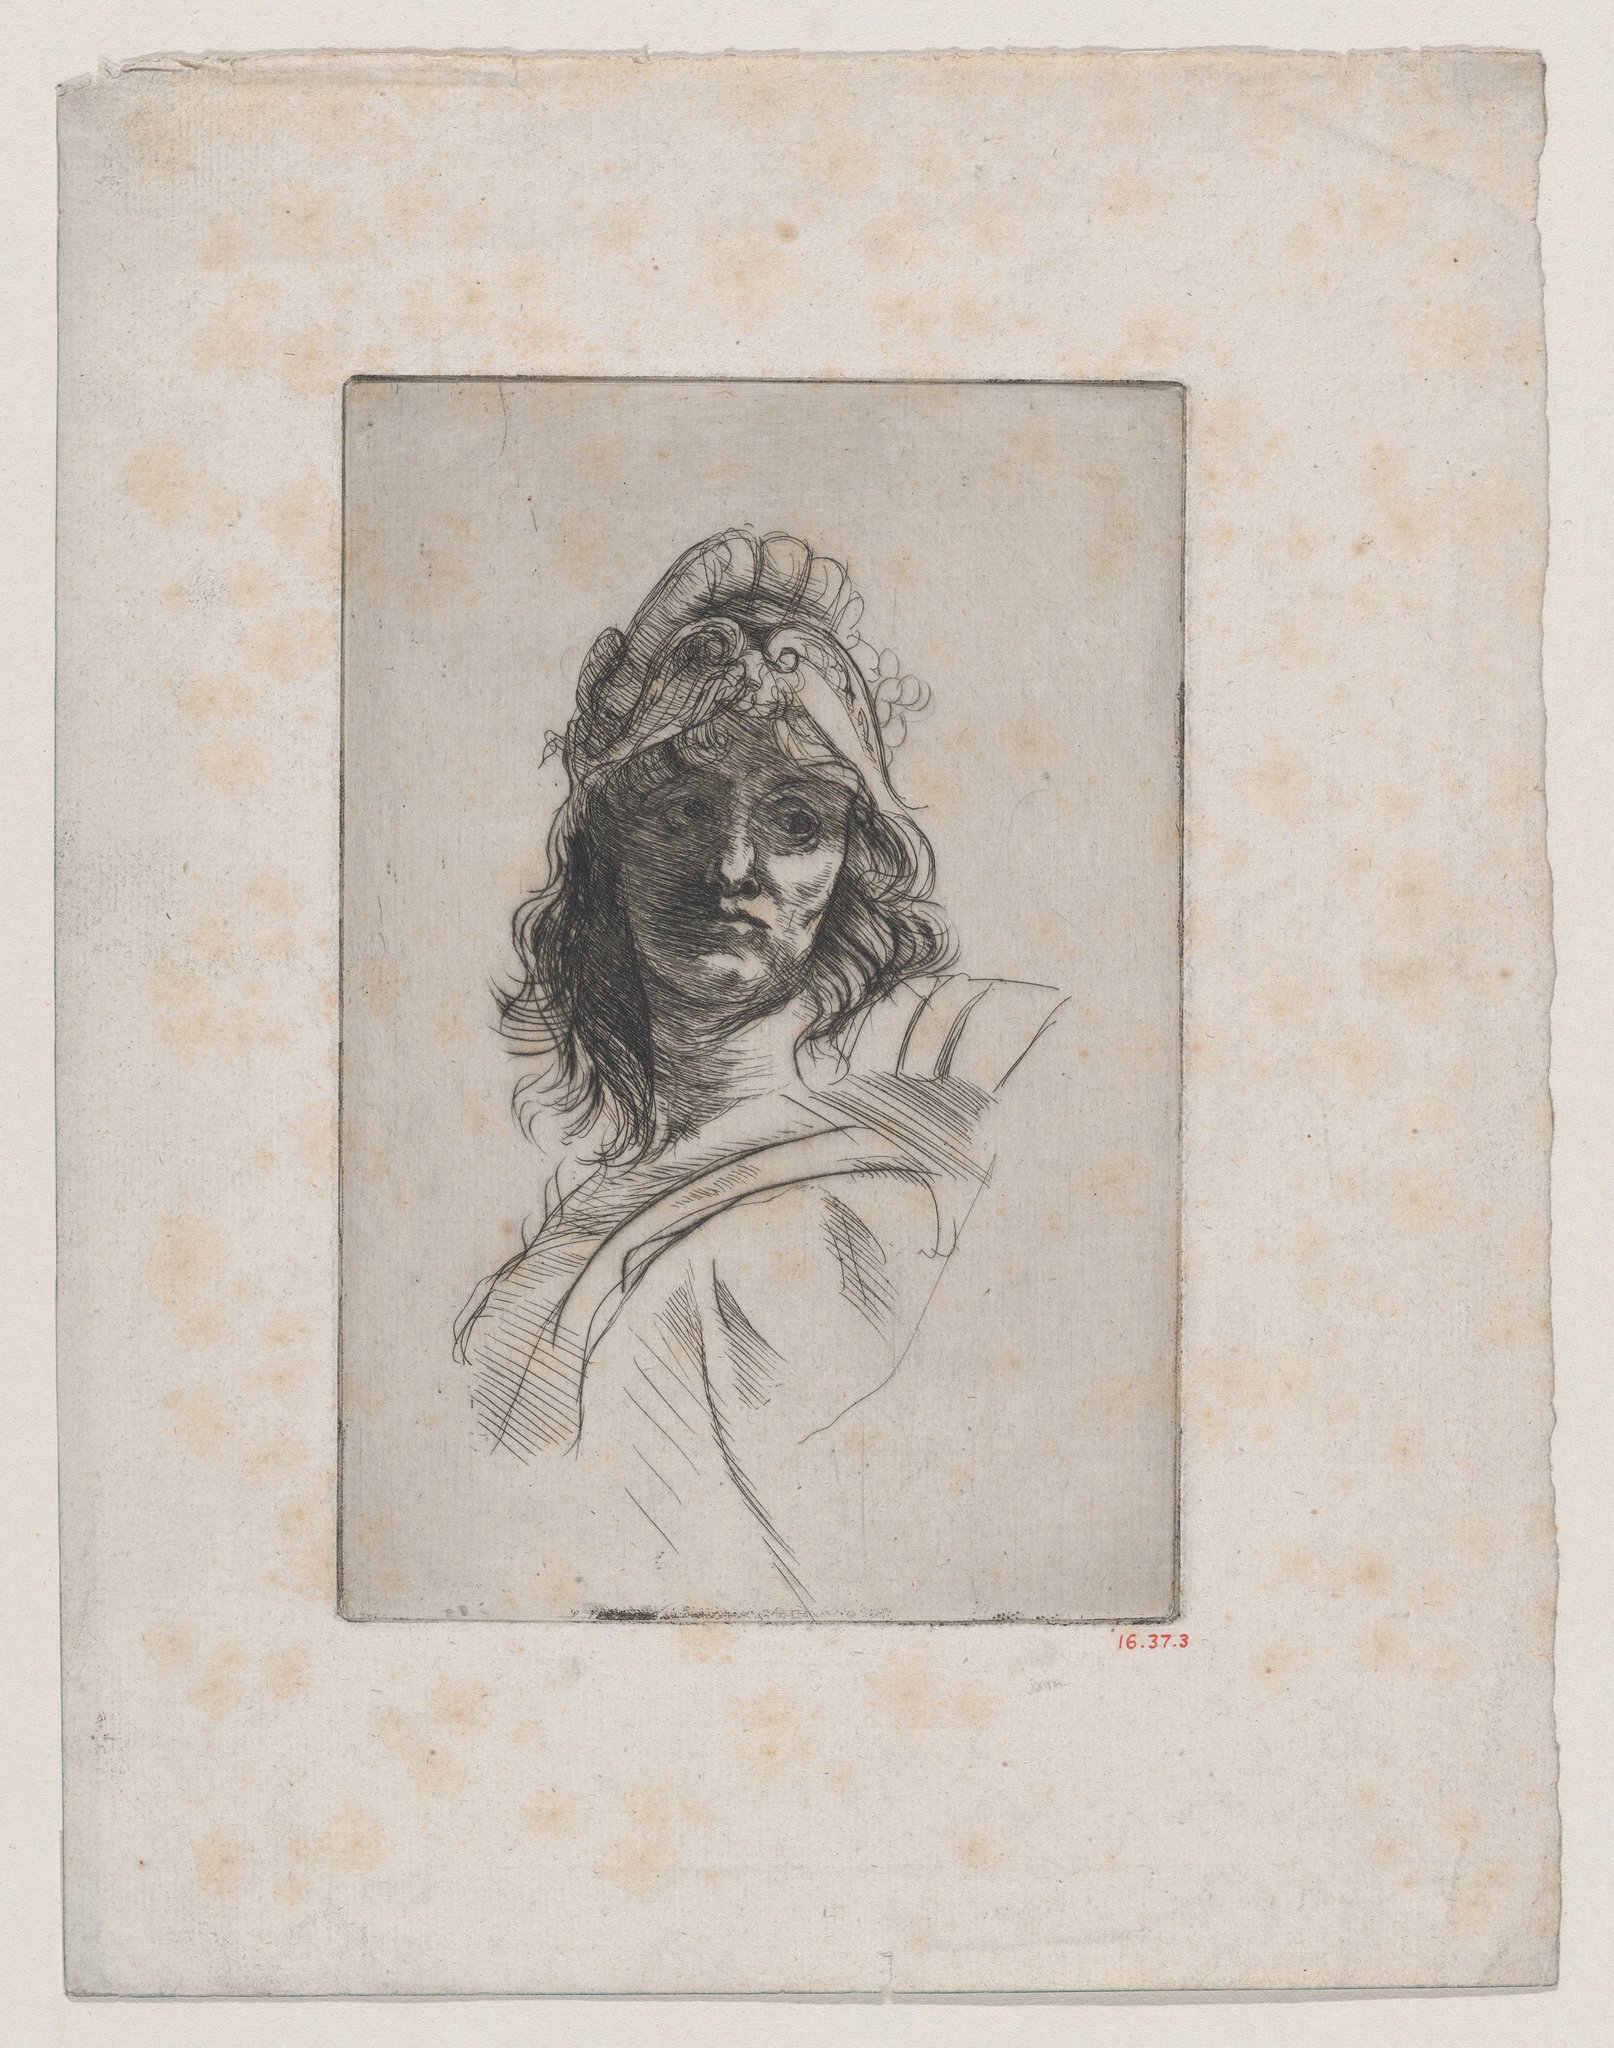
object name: print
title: Bust of Bellona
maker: auguste rodin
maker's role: artist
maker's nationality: french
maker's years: 1840-1917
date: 1882-1885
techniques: drypoint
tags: goddess